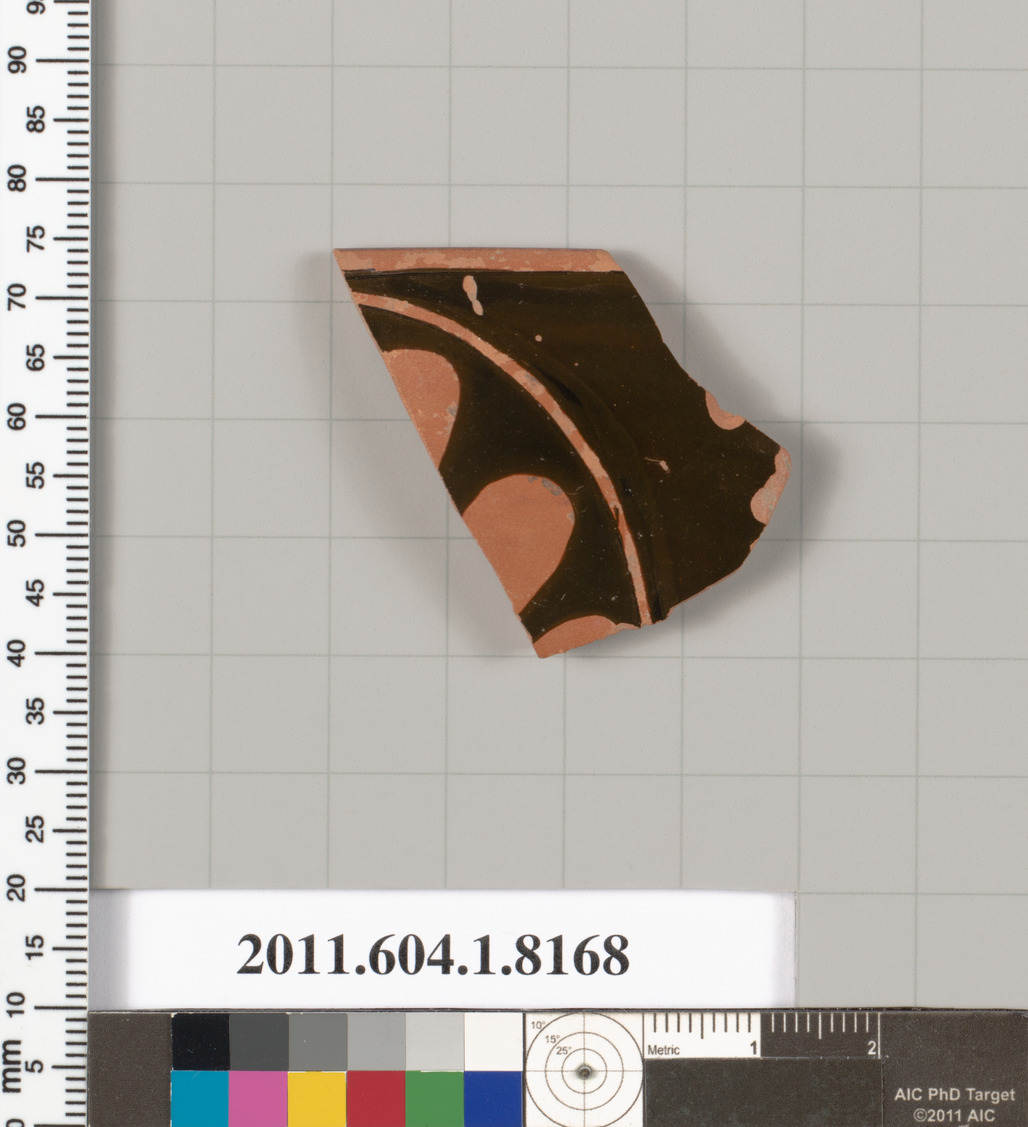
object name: kylix fragment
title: Terracotta rim fragment of a kylix (drinking cup)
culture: greek, attic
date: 520-510 BCE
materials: terracotta